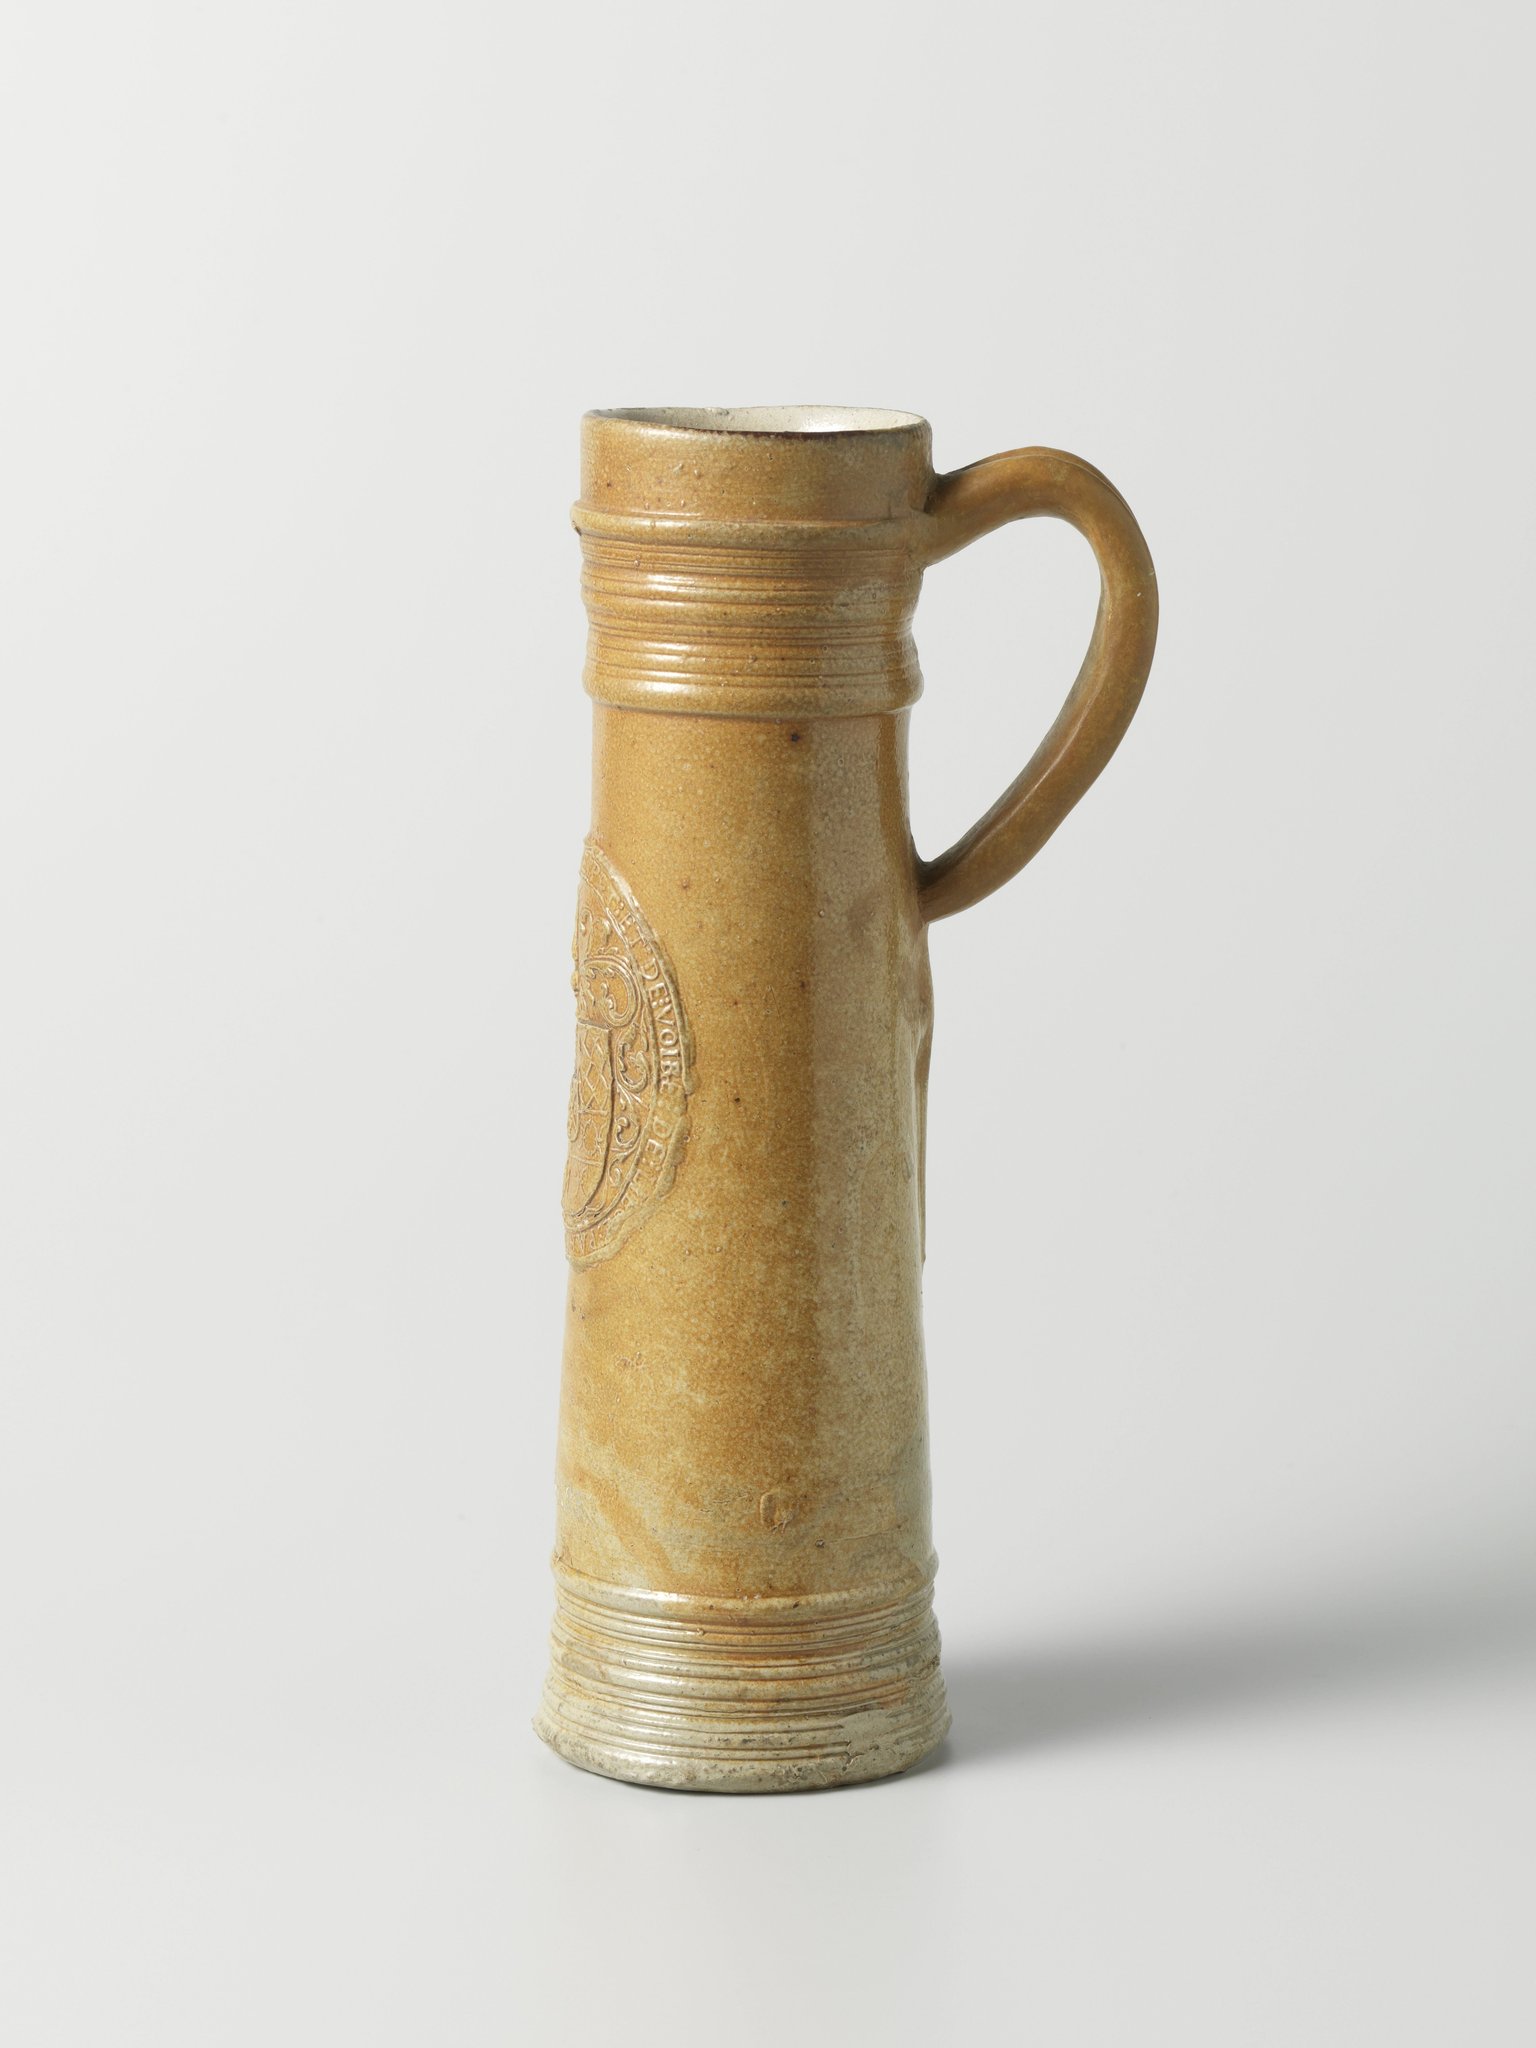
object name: jug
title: Tankard (schnelle) with a coat of arms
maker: Anonymous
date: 1550-1599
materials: engobe, glaze, stoneware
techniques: firing, forming, relief, turning, vitrification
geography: raeren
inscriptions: inscription: ‘DE POT ET DE VOIRE DE LIEGE PAR DIX FIS DEESTENE APVELEN PAR [...]’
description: Kruik (schnelle) van steengoed met cilindervormig, taps toelopend lichaam en C-vormig oor. Profielen onder de rand en boven de voet. Bedekt met een bruine engobe. Op het lichaam in reliëf een gedrukt en opgelegd medaillon met een wapen en het randschrift 'DE POT ET DE VOIRE DE LIEGE PAR DIX FIS DEESTENE APVELEN PAR [...]'. Raeren.